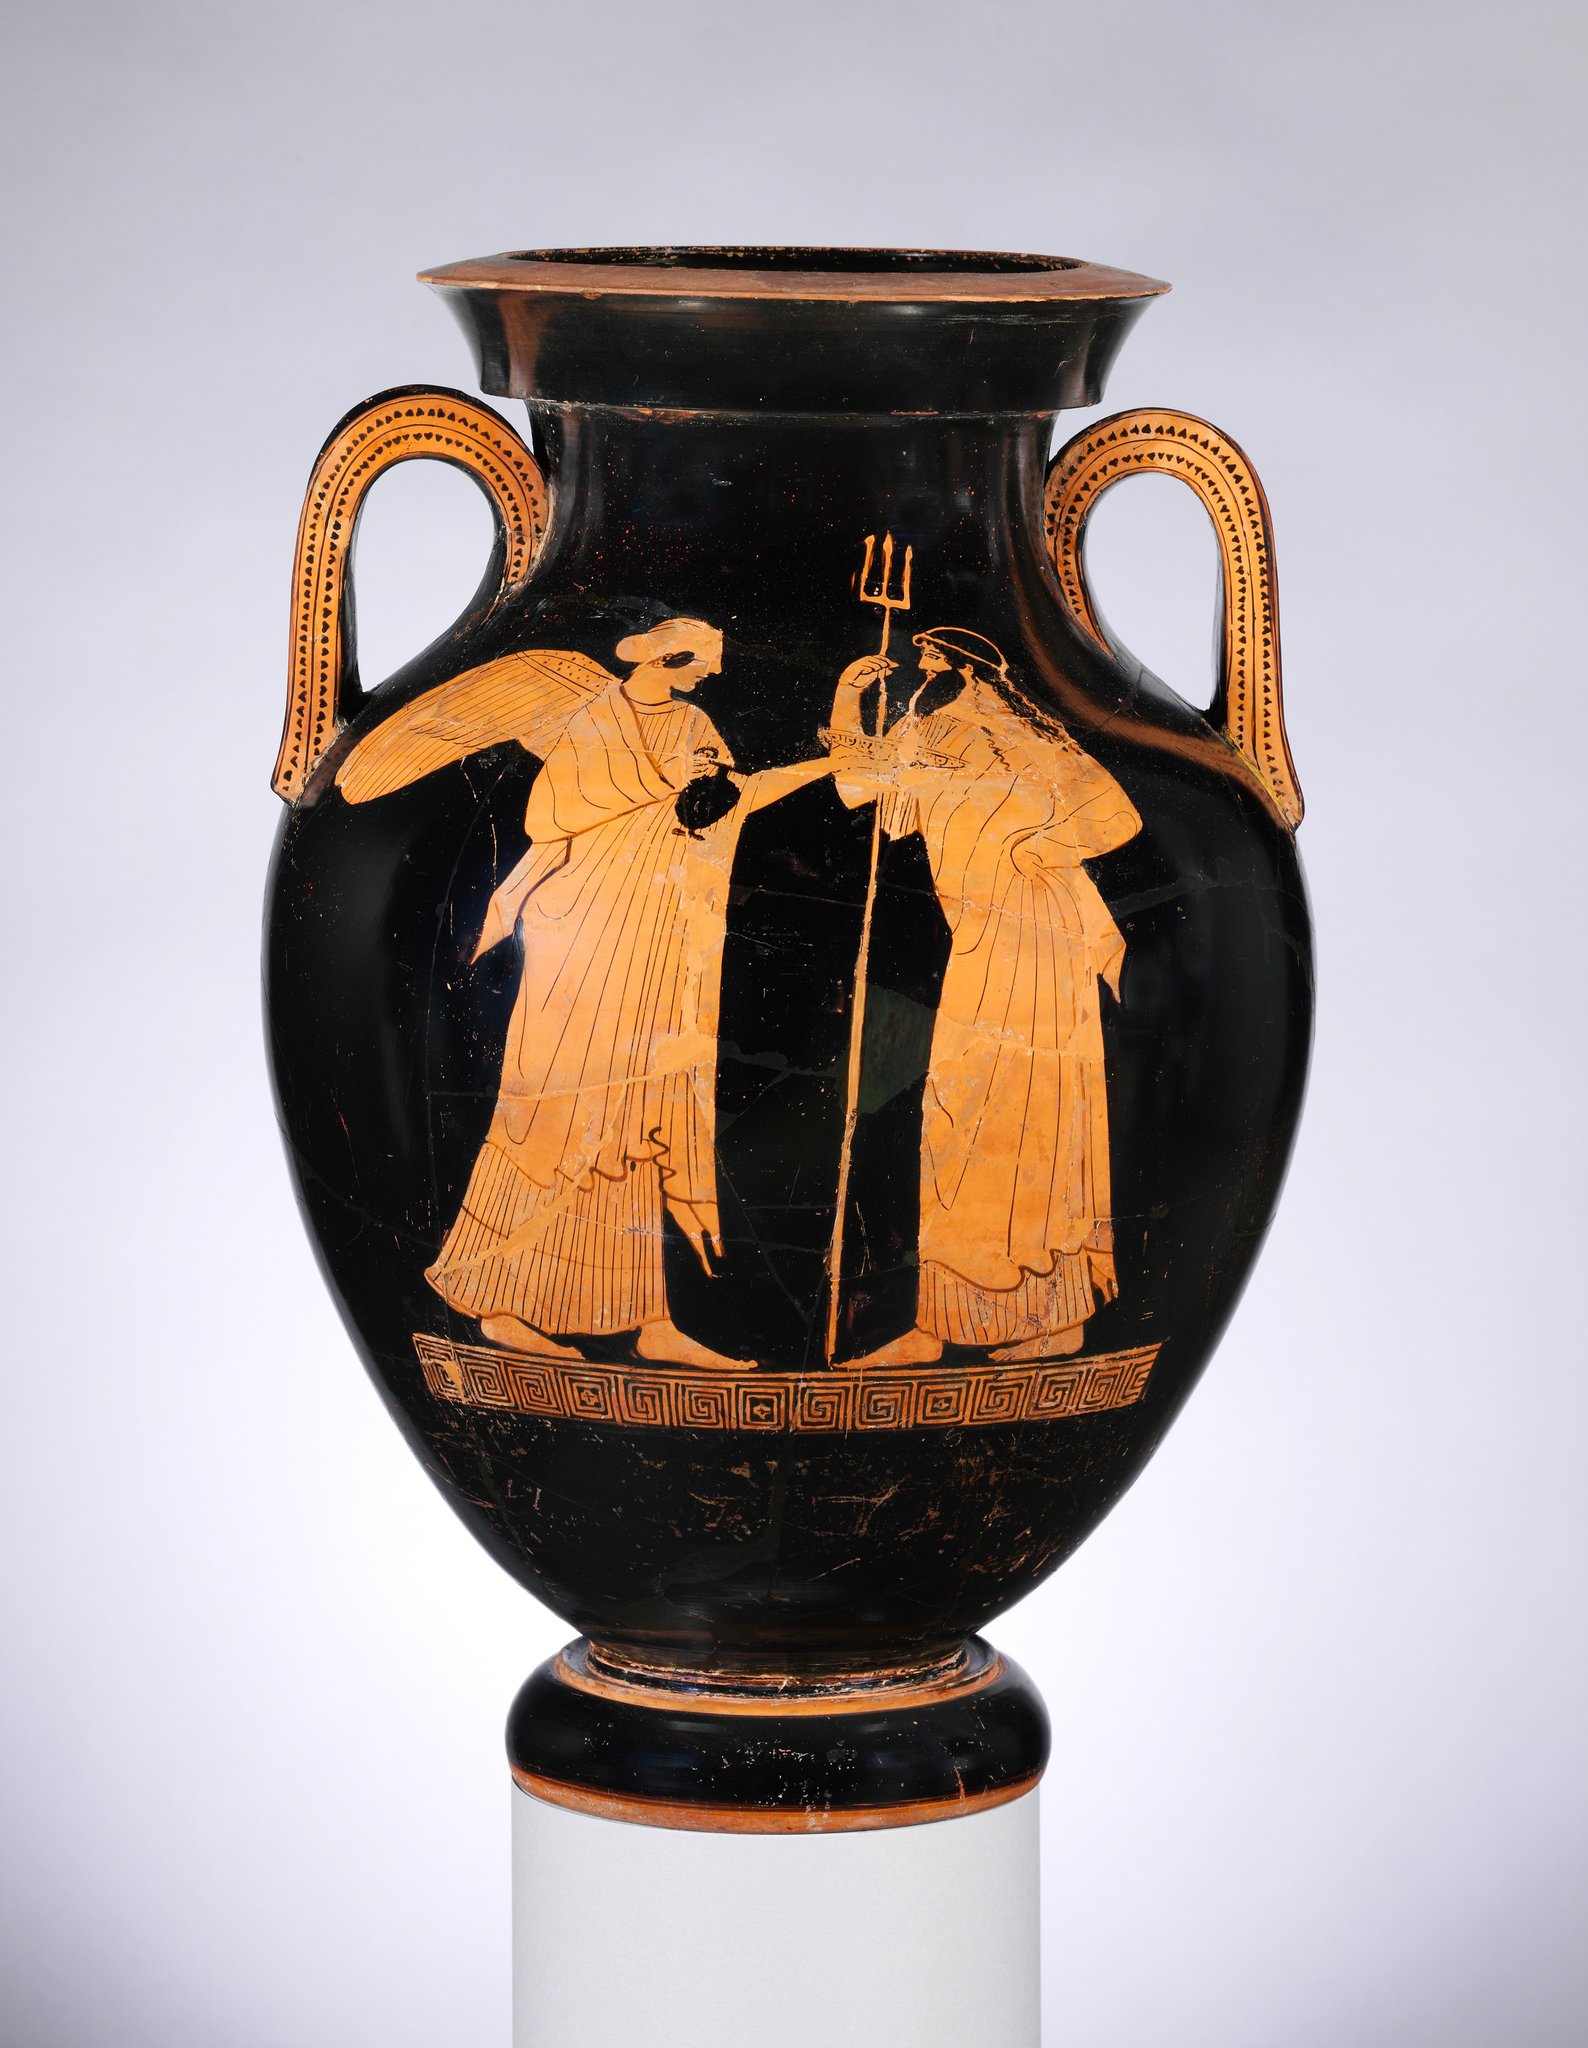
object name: amphora, type a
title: Terracotta amphora (jar)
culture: greek, attic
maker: syracuse painter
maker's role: artist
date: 470-460 BCE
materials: terracotta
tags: dionysus,nike